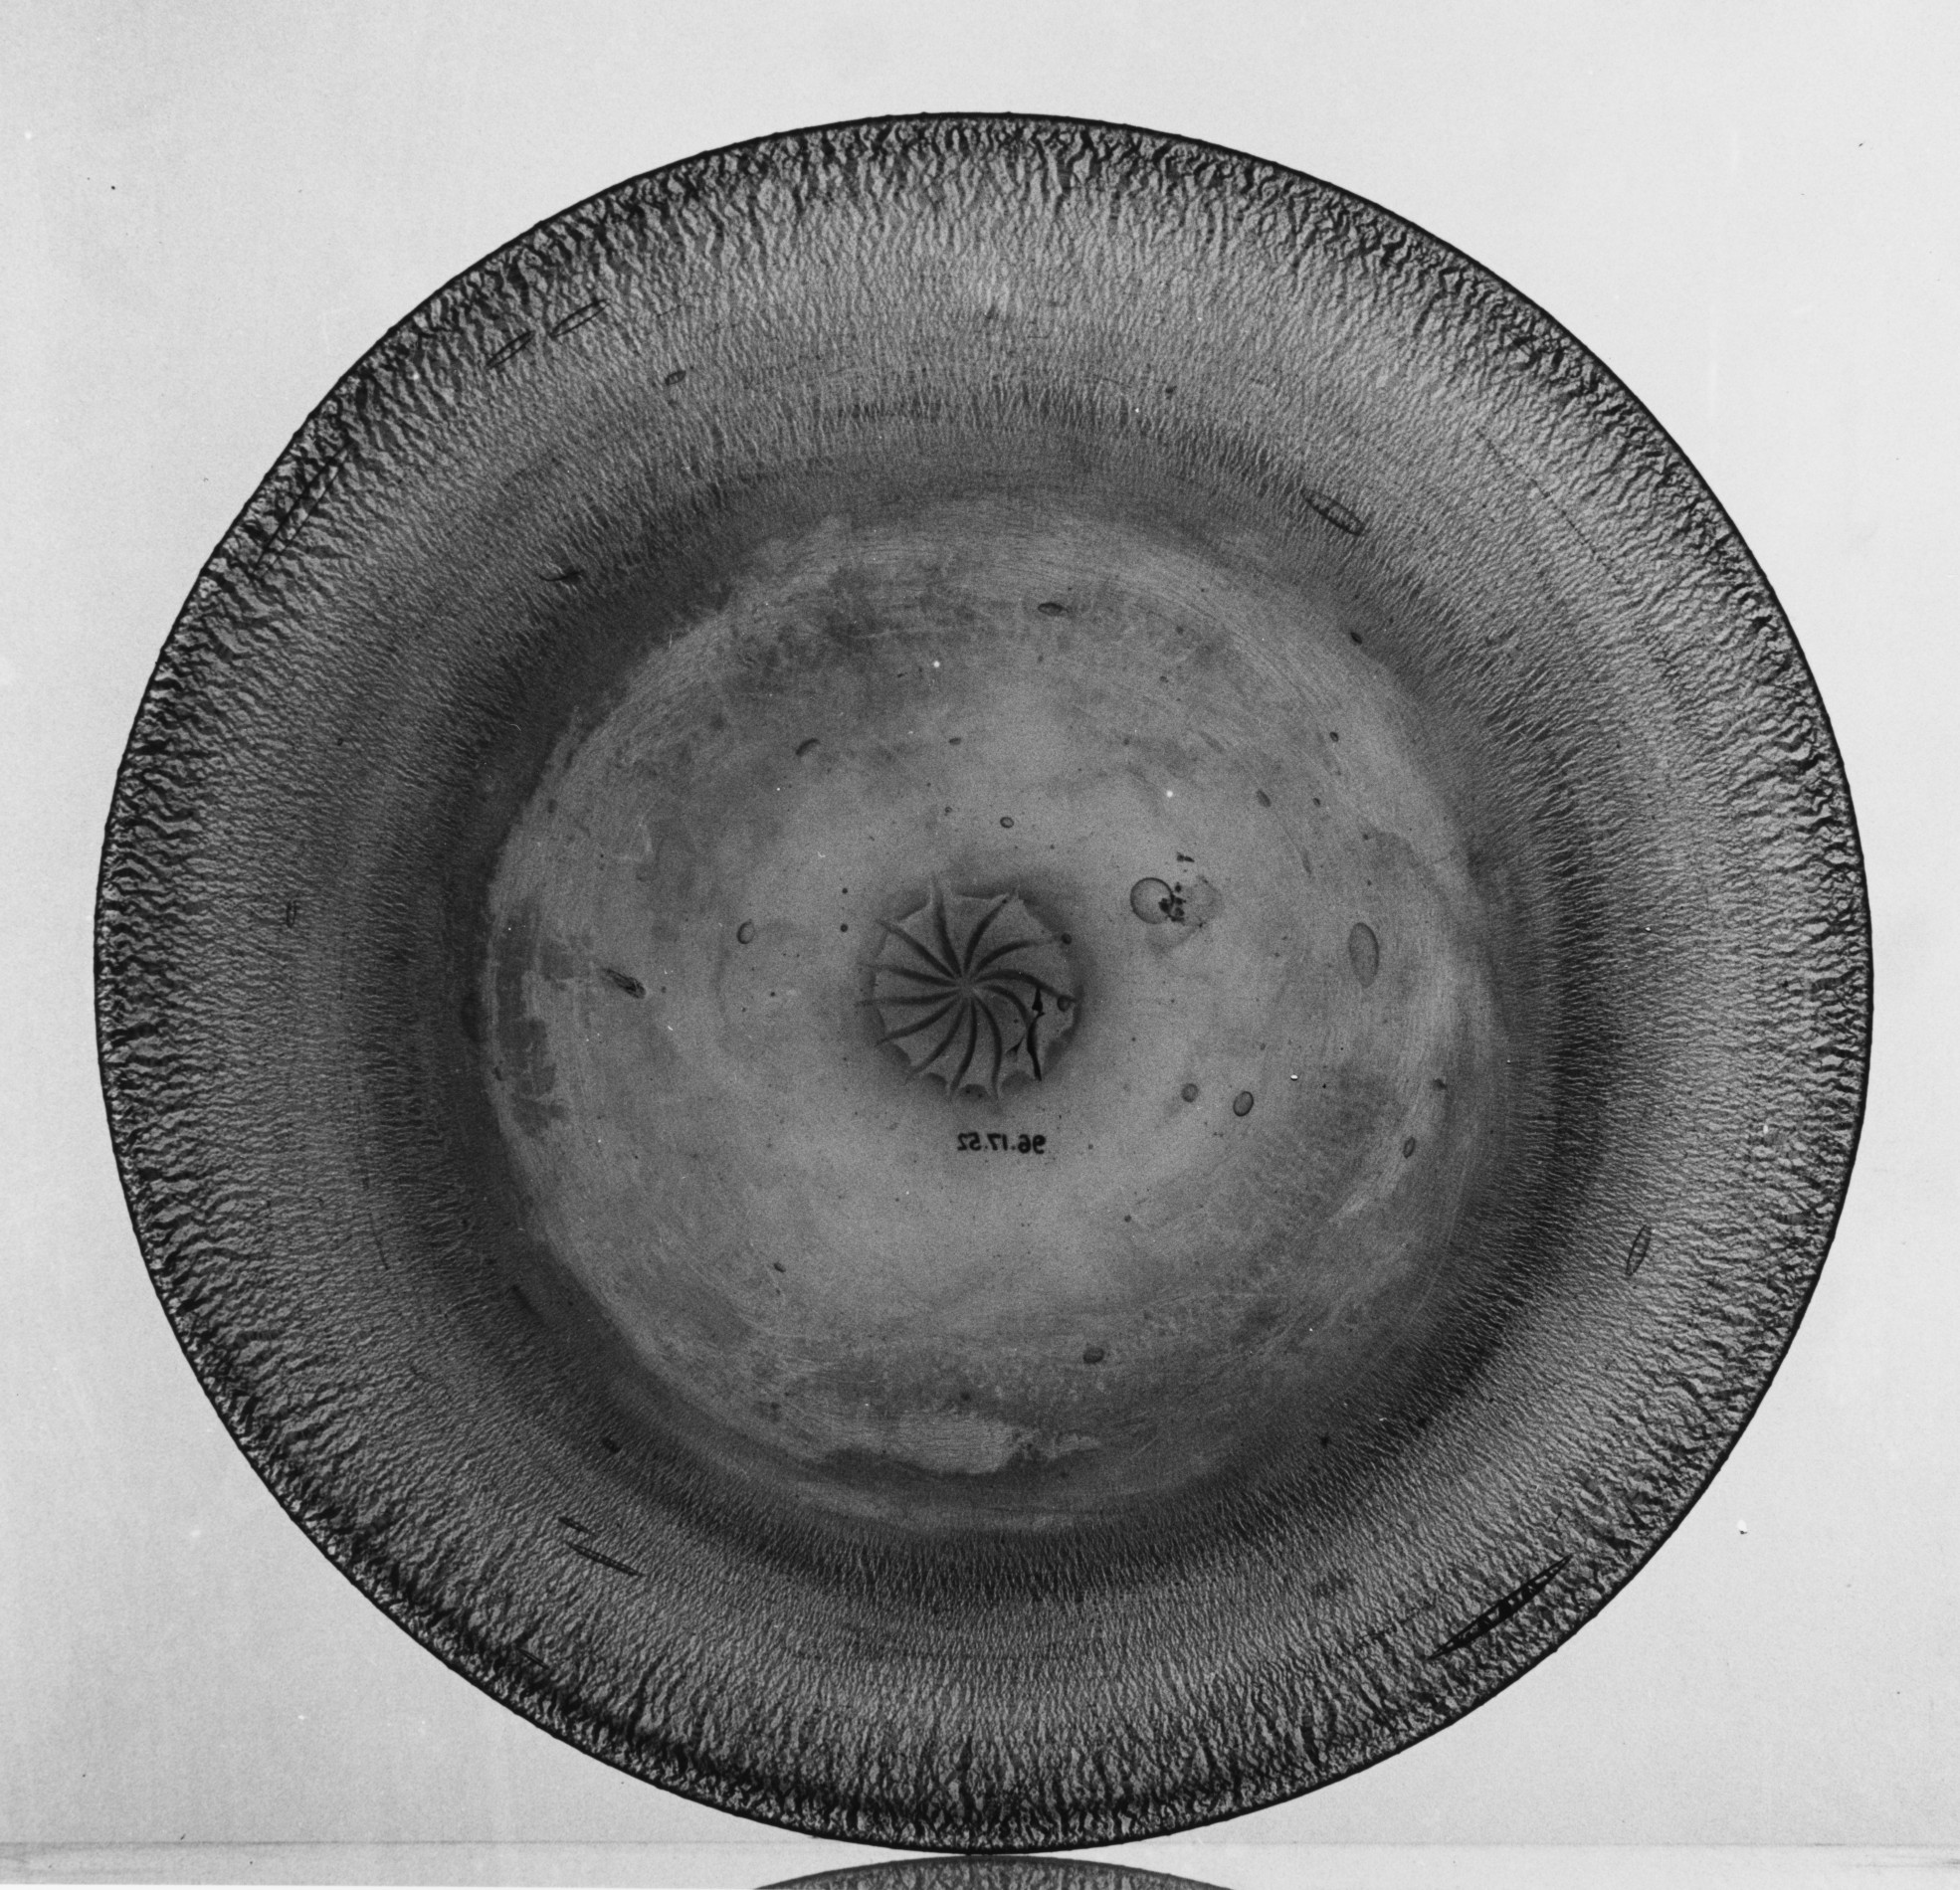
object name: plaque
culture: american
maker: louis c. tiffany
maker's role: designer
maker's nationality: american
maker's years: 1848-1933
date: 1893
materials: glass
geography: united states